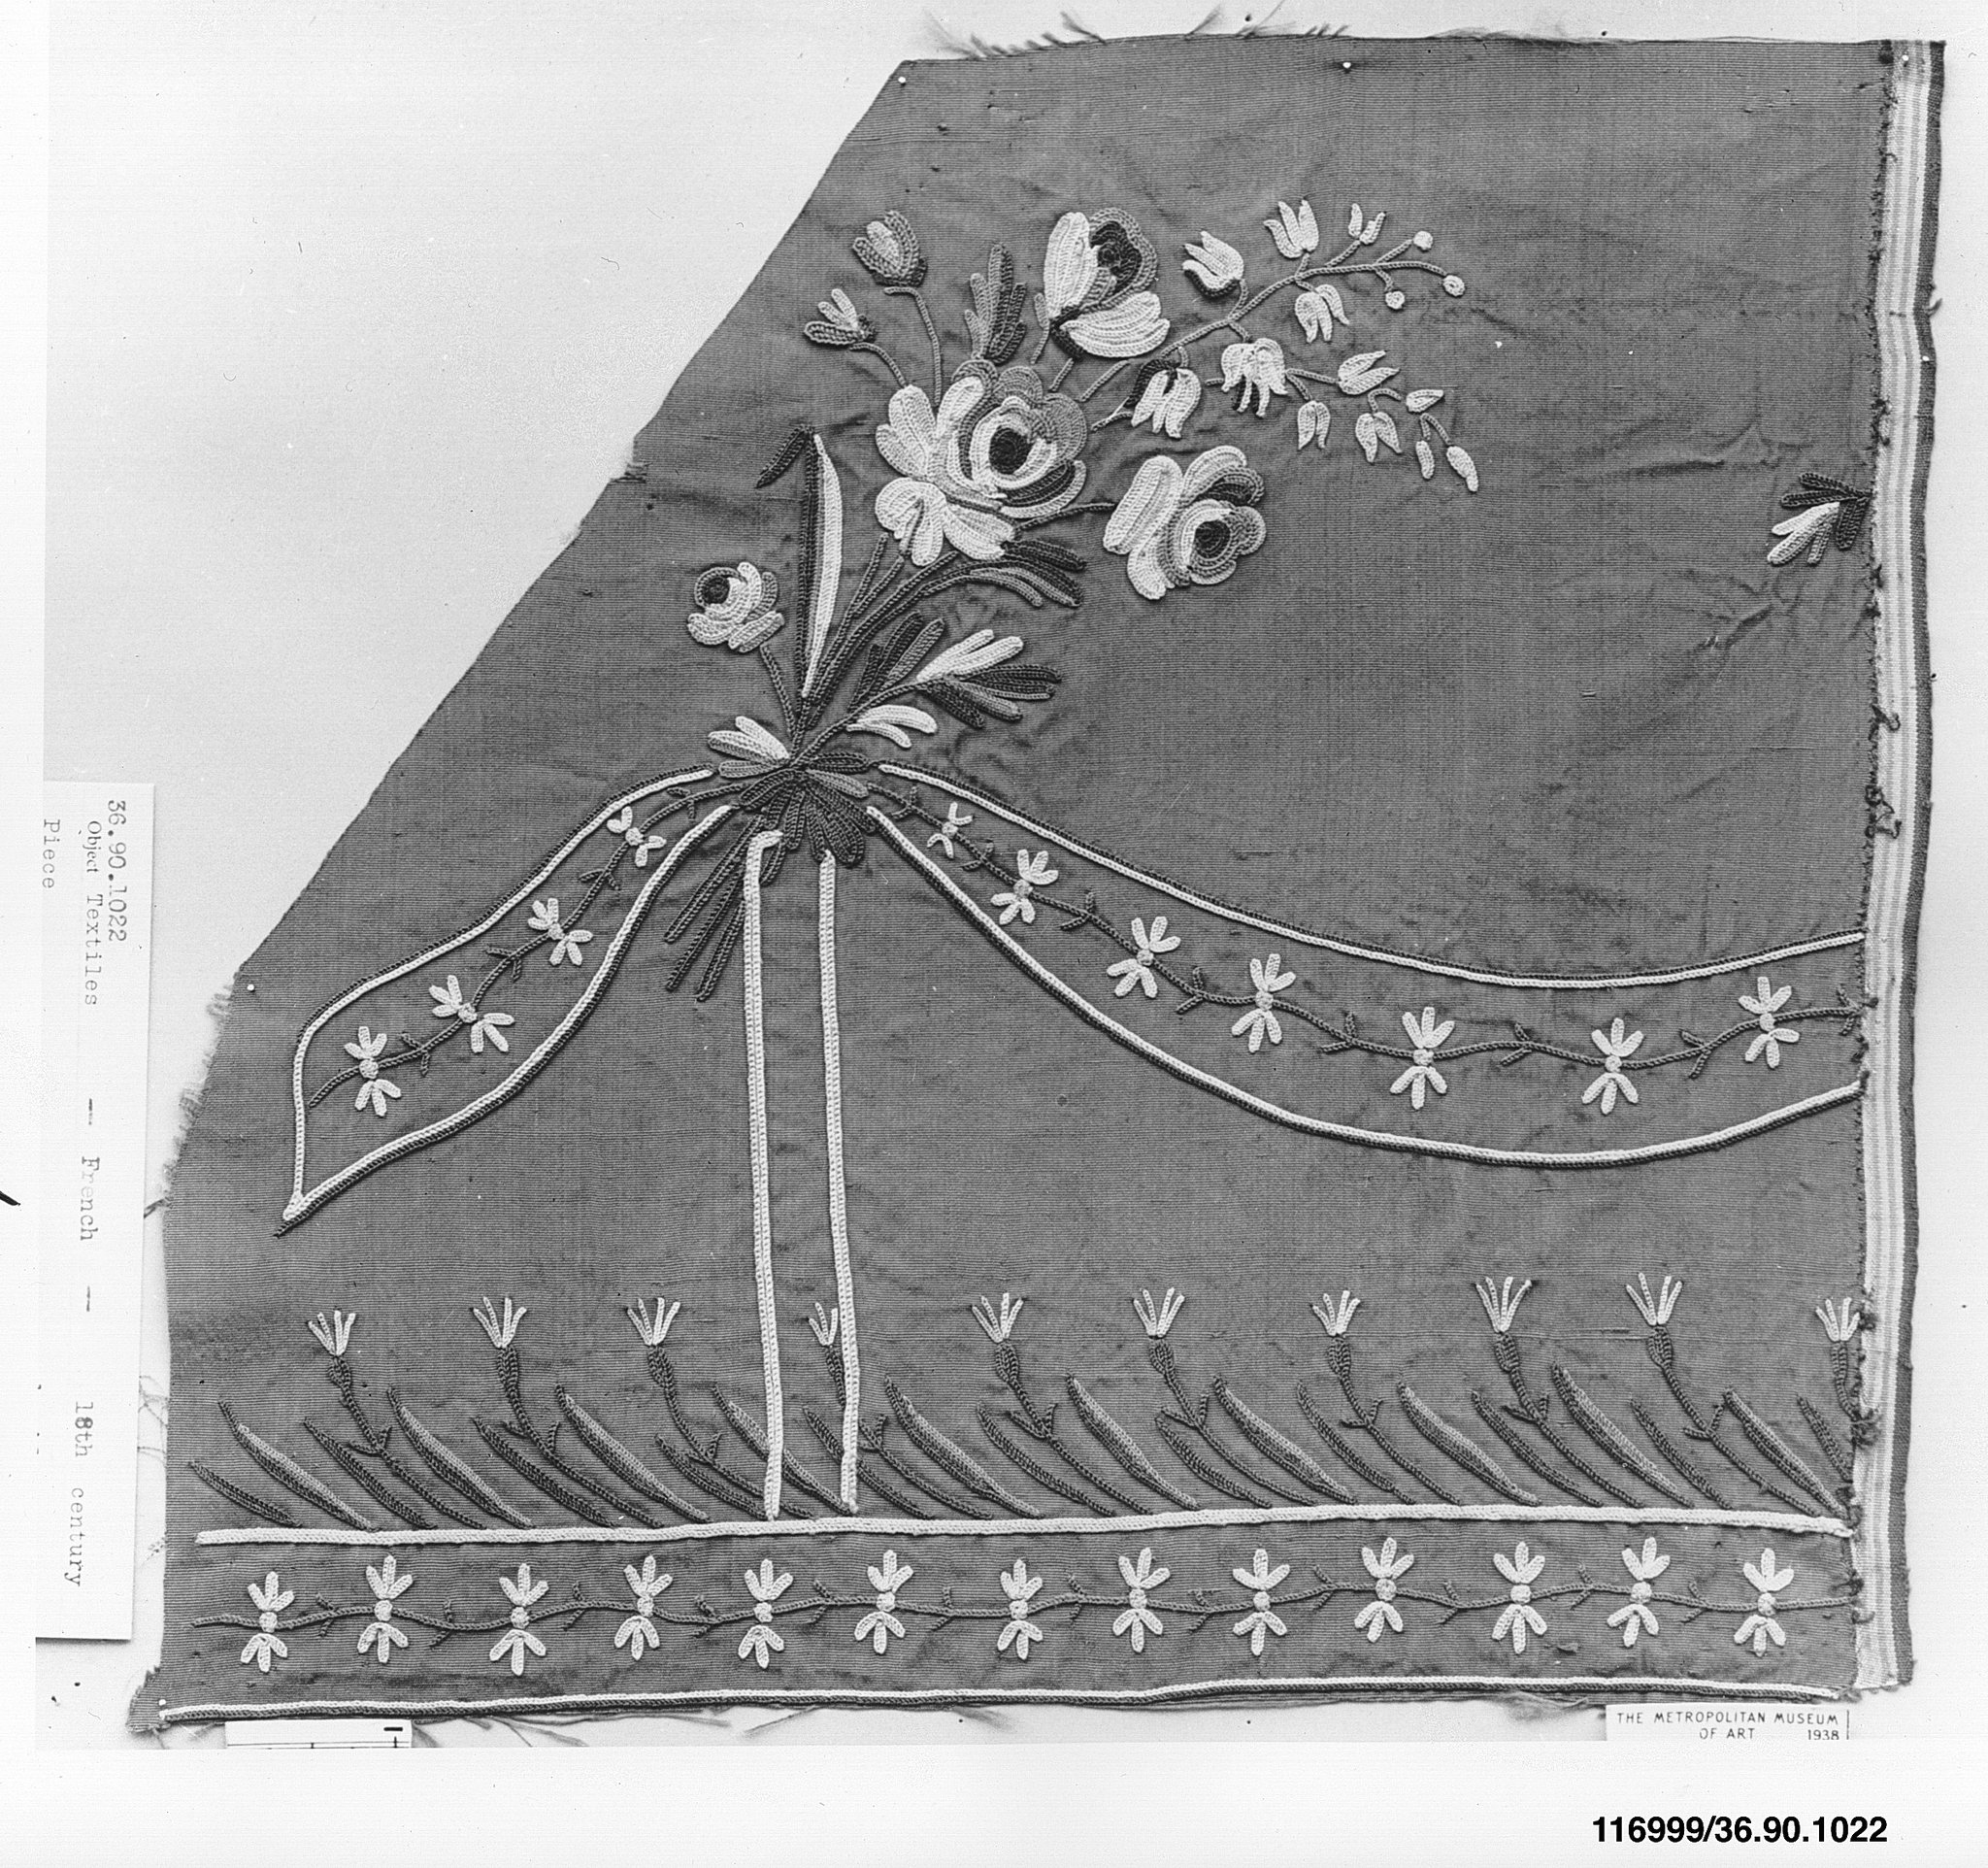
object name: sample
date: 1701-1800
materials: silk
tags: flowers,leaves